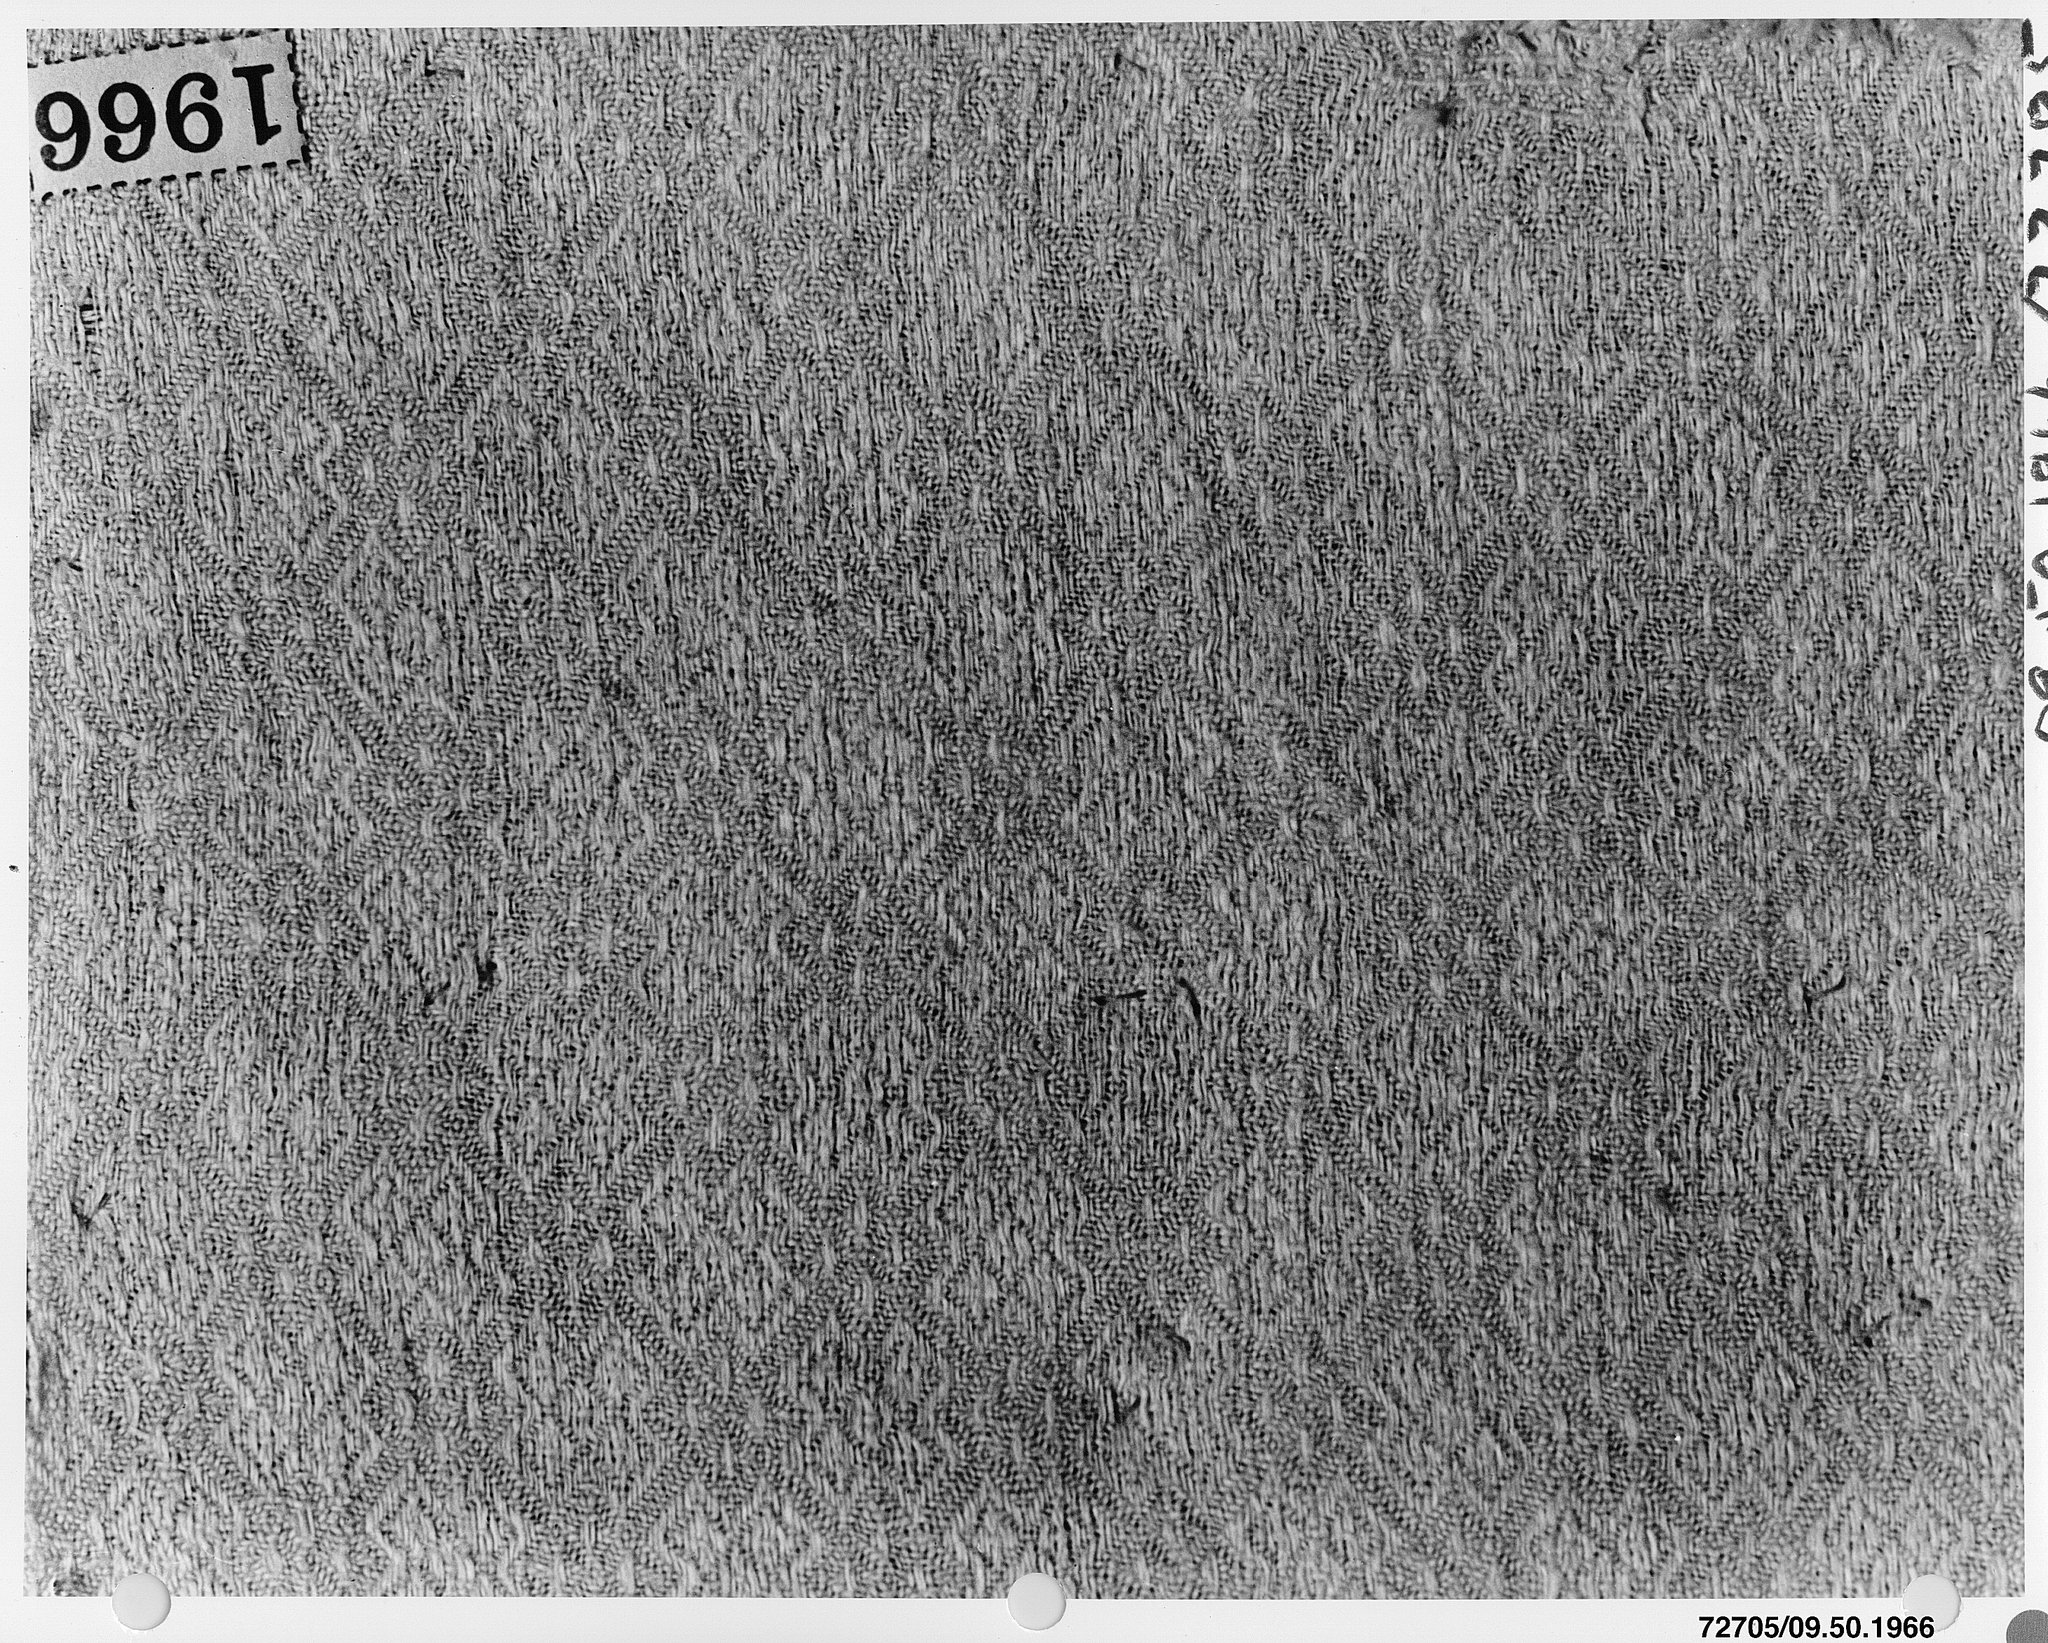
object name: fragment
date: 1701-1900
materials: linen